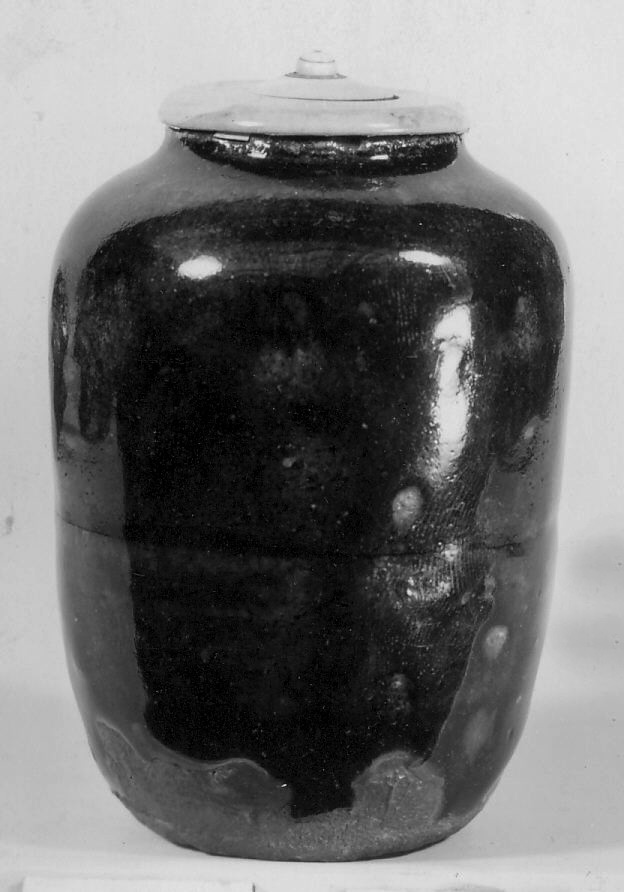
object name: tea jar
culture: japanese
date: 1701-1800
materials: clay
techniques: overglaze, underglaze